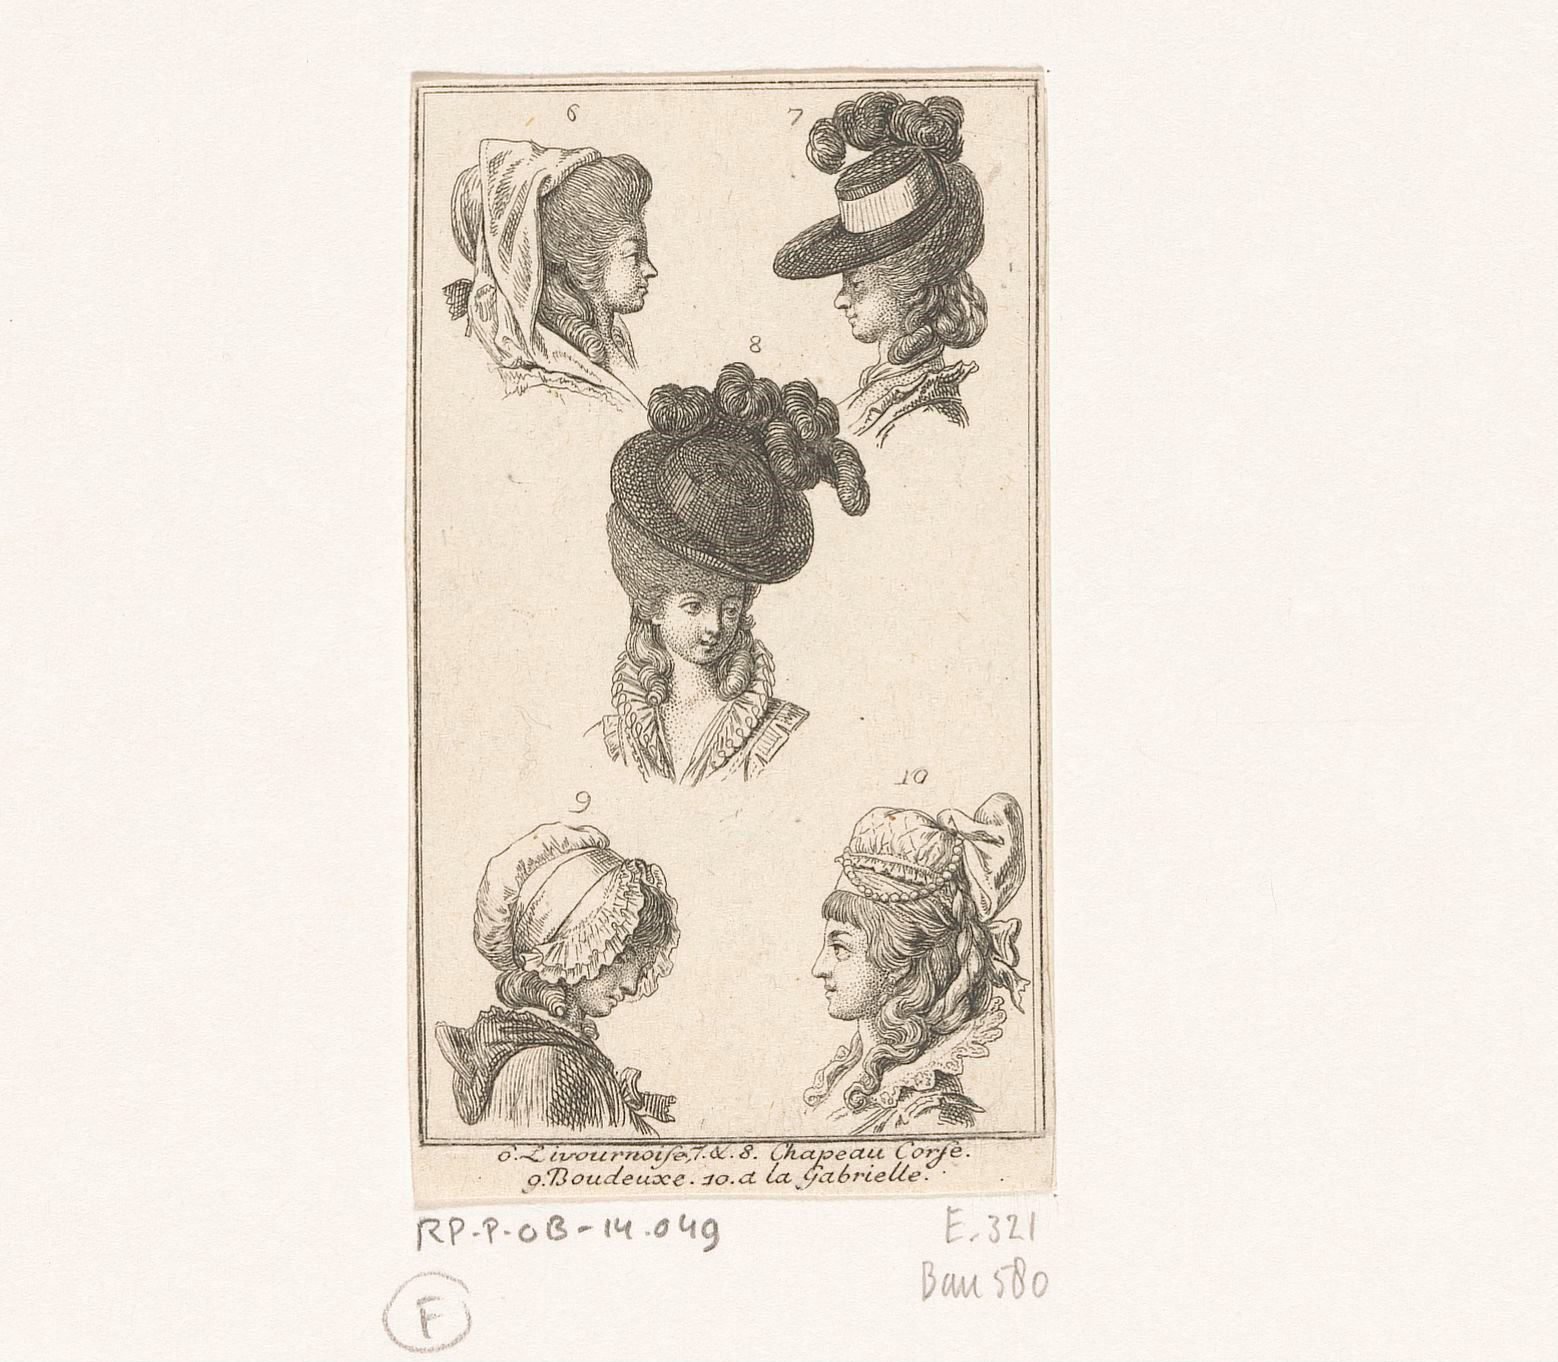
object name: fashion print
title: Verschillende dameskapsels en hoofddeksels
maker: daniel nikolaus chodowiecki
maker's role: draughtsman, print maker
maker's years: 1726-1801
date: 1779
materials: paper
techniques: etching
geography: berlin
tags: styles of hairdress - aa - ~ women, head-gear: cap (+ women's clothes), head-gear: hat (+ women's clothes)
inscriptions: collector's mark: Lugt 2228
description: Prent ook gebruikt in: Göttinger Taschen Calender vom Jahre 1779.